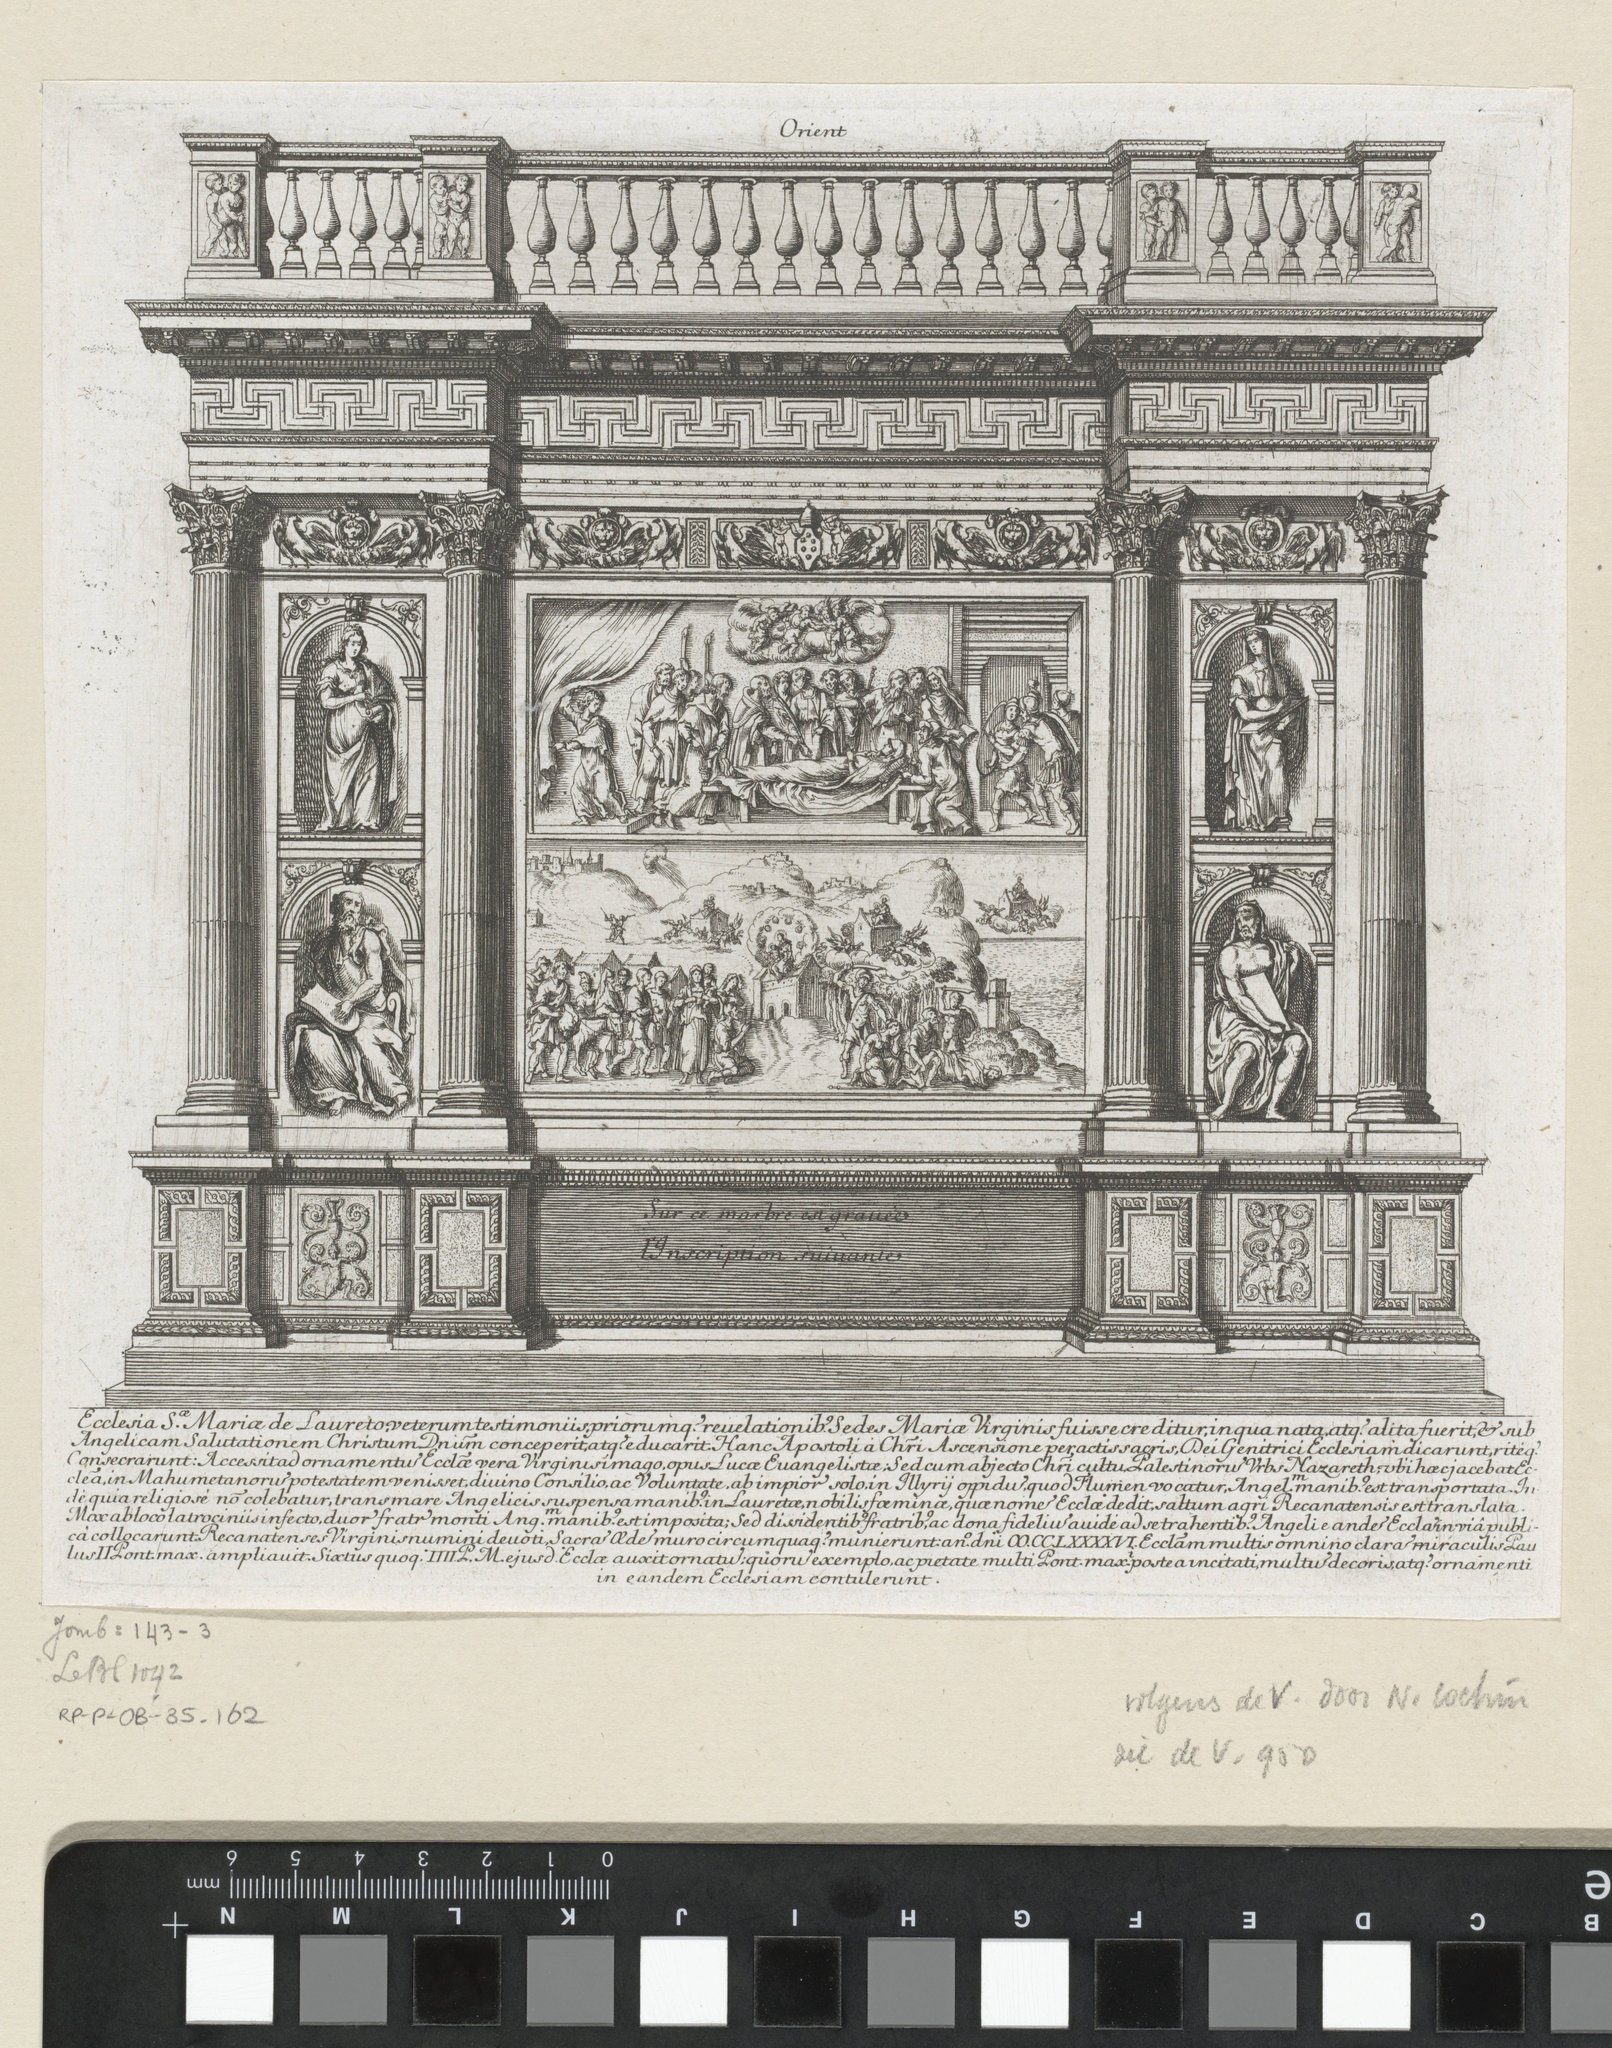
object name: print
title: Heilig Huis van de Maagd Maria, orient-zijde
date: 1649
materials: paper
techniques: etching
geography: france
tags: parts of church interior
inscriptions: collector's mark: Lugt 240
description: De orient-zijde van de marmeren renaissance behuizing van het Heilig Huis van de Maagd Maria in de Basilica della Casa Santa in Loreto. De behuizing bevat beelden en reliëfs door Andrea Sansovino, Ranieri Nerucci en Antonio da Sangallo de Jongere. Het geheel is ontworpen door Donato Bramante.